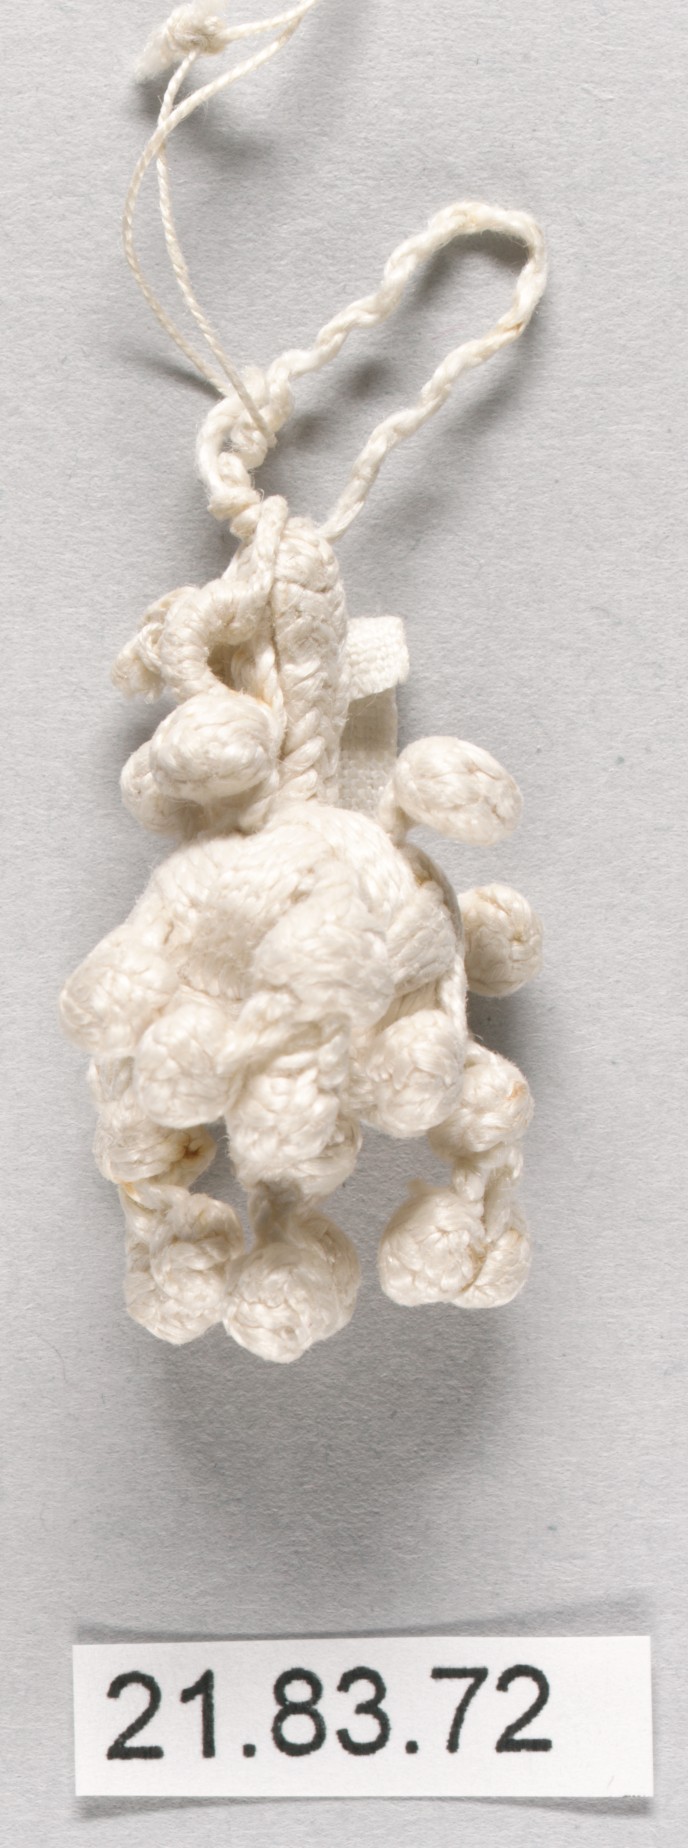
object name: tassel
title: Pair of tassels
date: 1601-1700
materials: linen